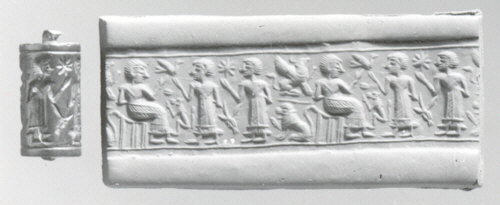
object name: cylinder seal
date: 1820-1730 BCE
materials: bronze, mineral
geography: syria